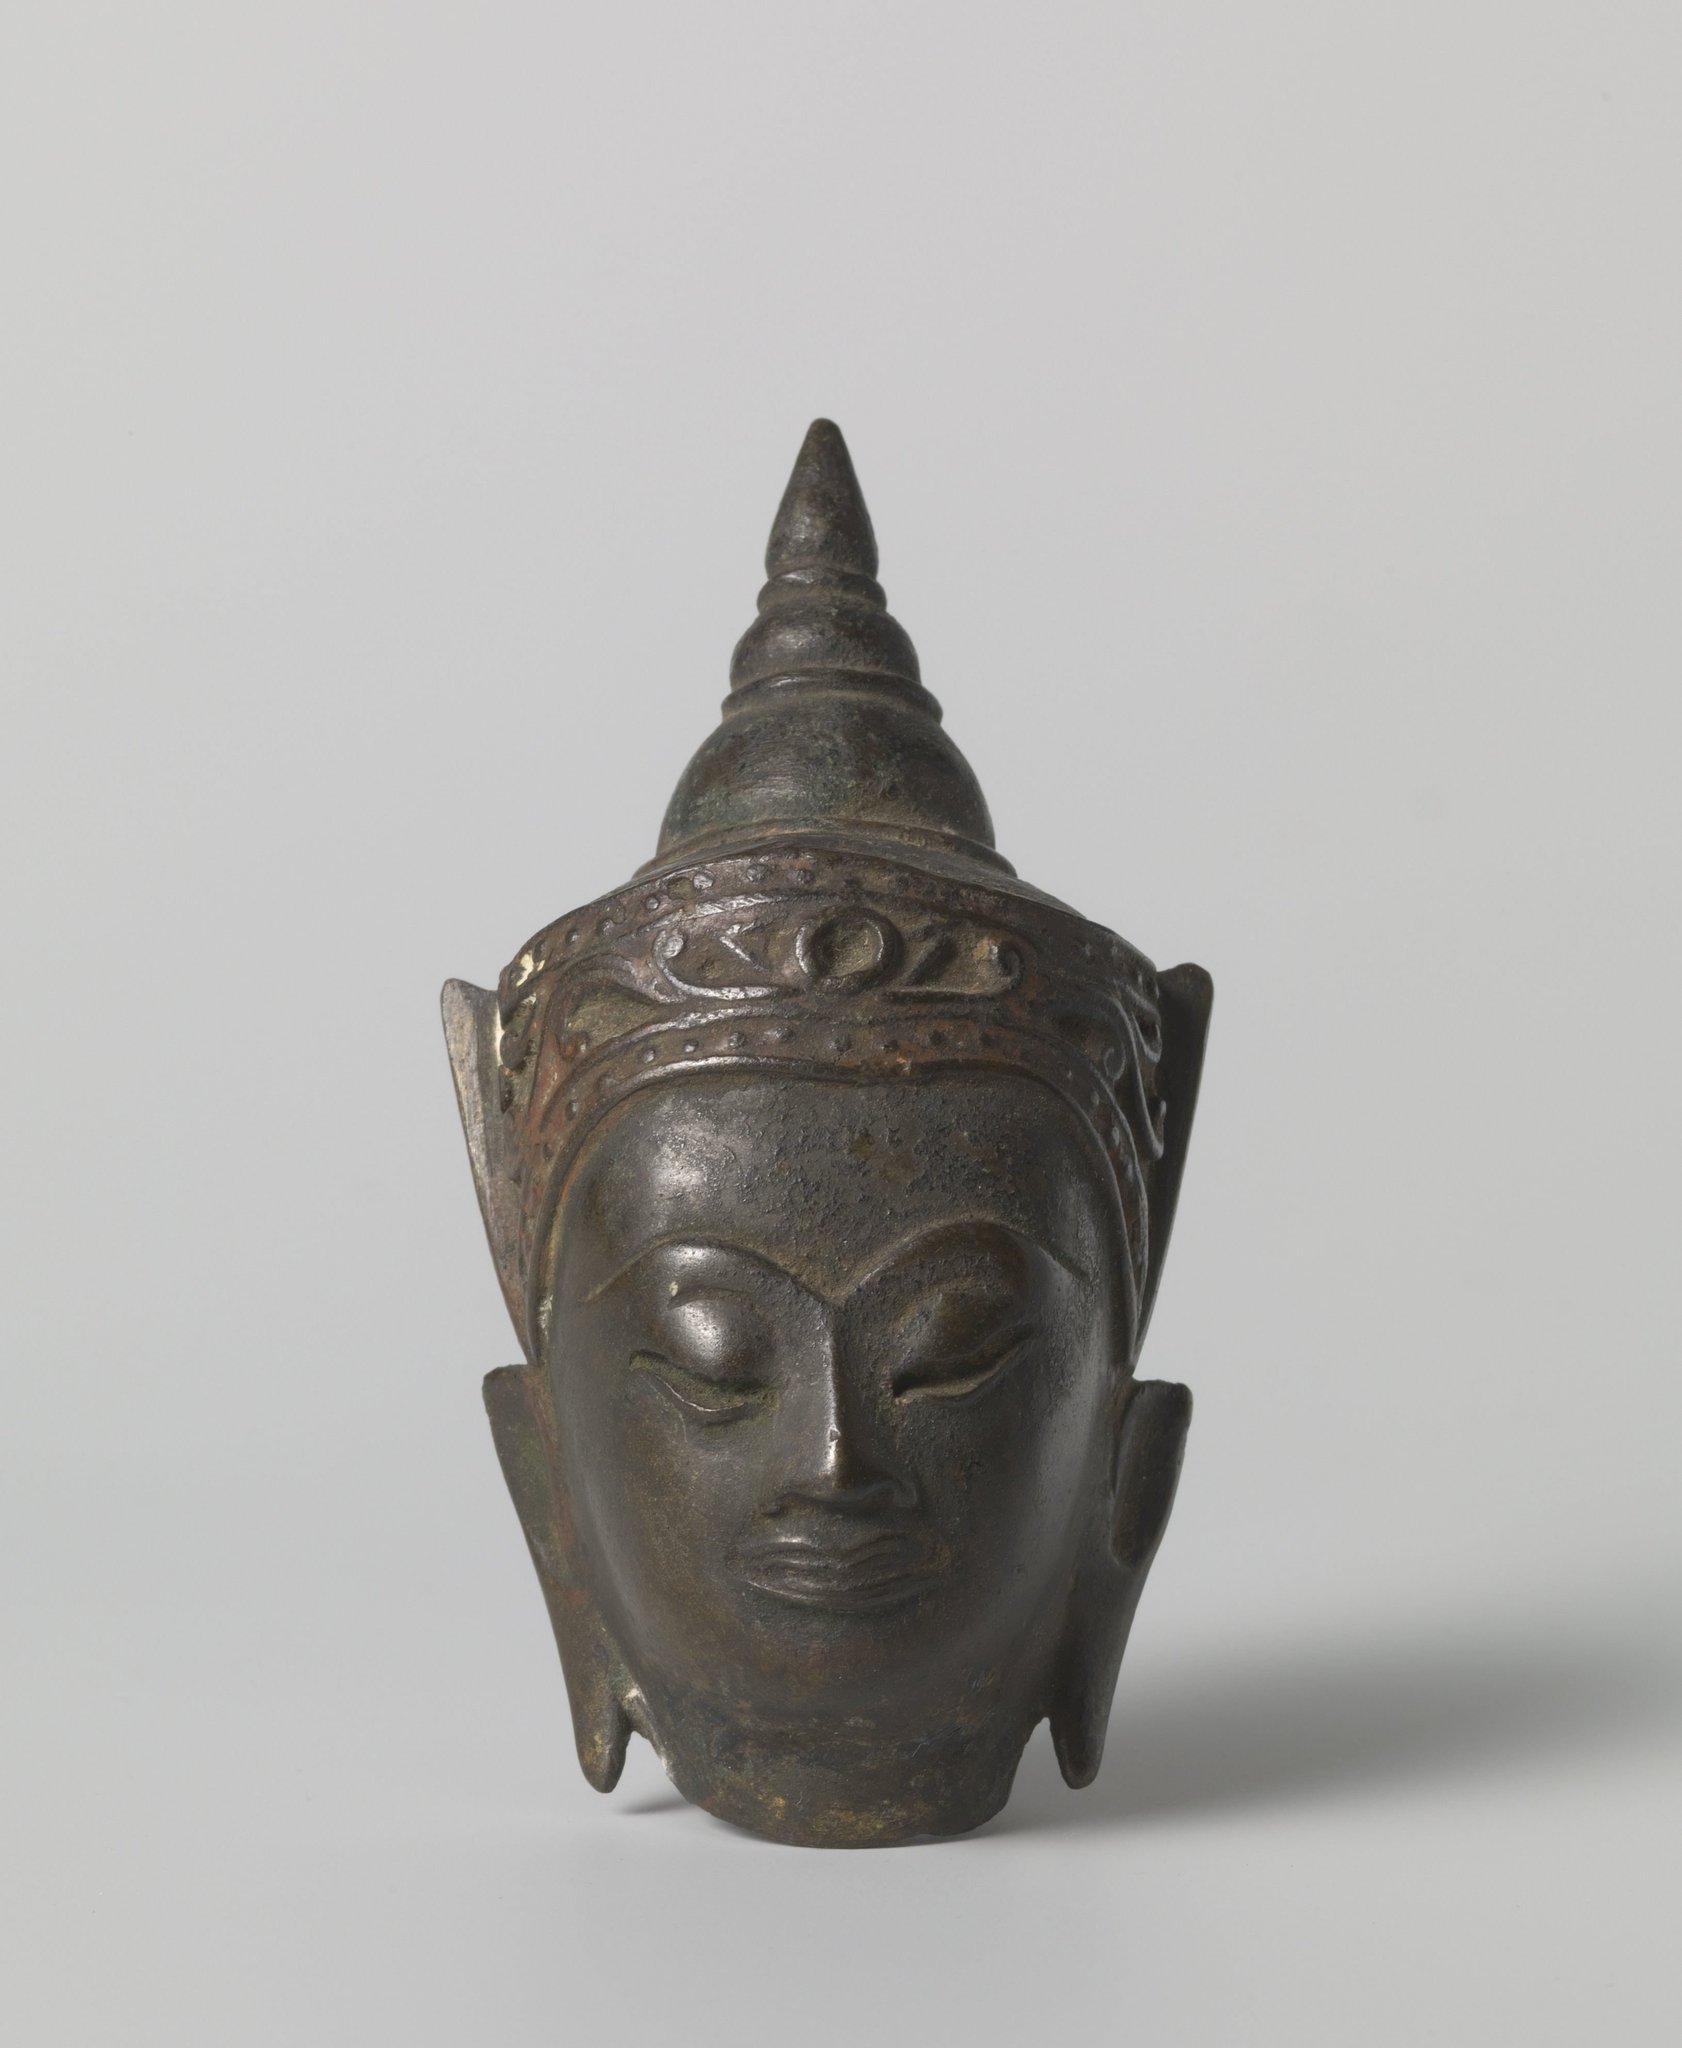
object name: boeddha kop, boeddha beeld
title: Hoofd van een Boeddha-beeld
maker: Anonymous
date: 1600-1699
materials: bronze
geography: thailand